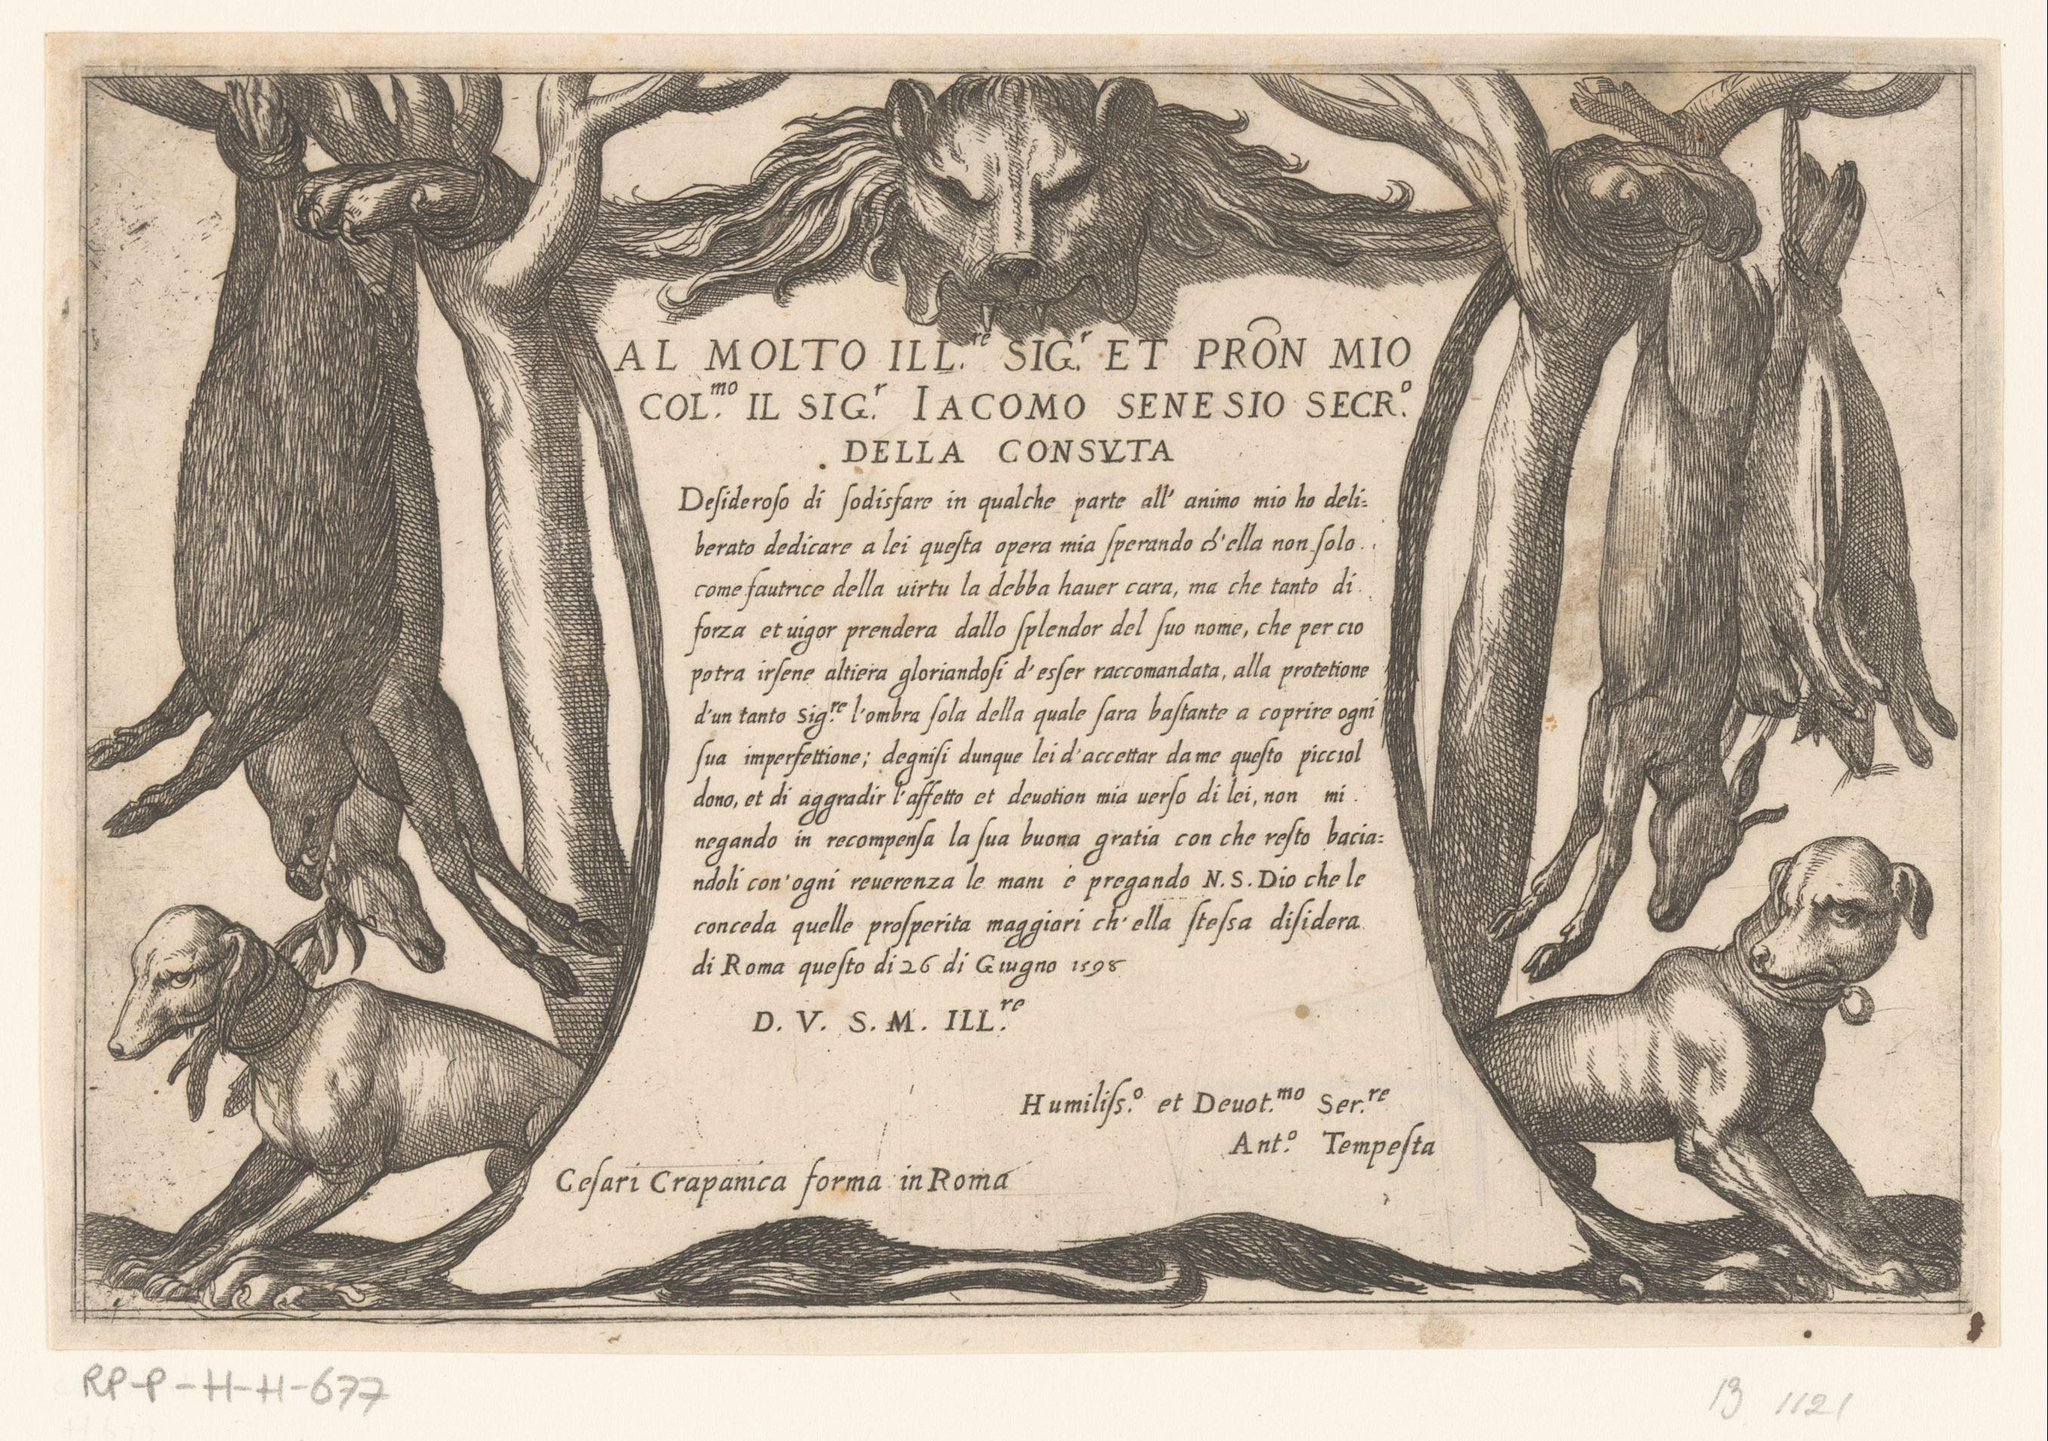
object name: print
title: Jachtscènes (deel 4)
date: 1595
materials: paper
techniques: etching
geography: rome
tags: hunting dogs, hunting dogs beside the spoils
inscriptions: number: ‘1’, number: ‘1’, collector's mark: ‘Hinloopen’, collector's mark: Lugt 11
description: Opdracht bij een reeks van elf prenten met jachtscènes.